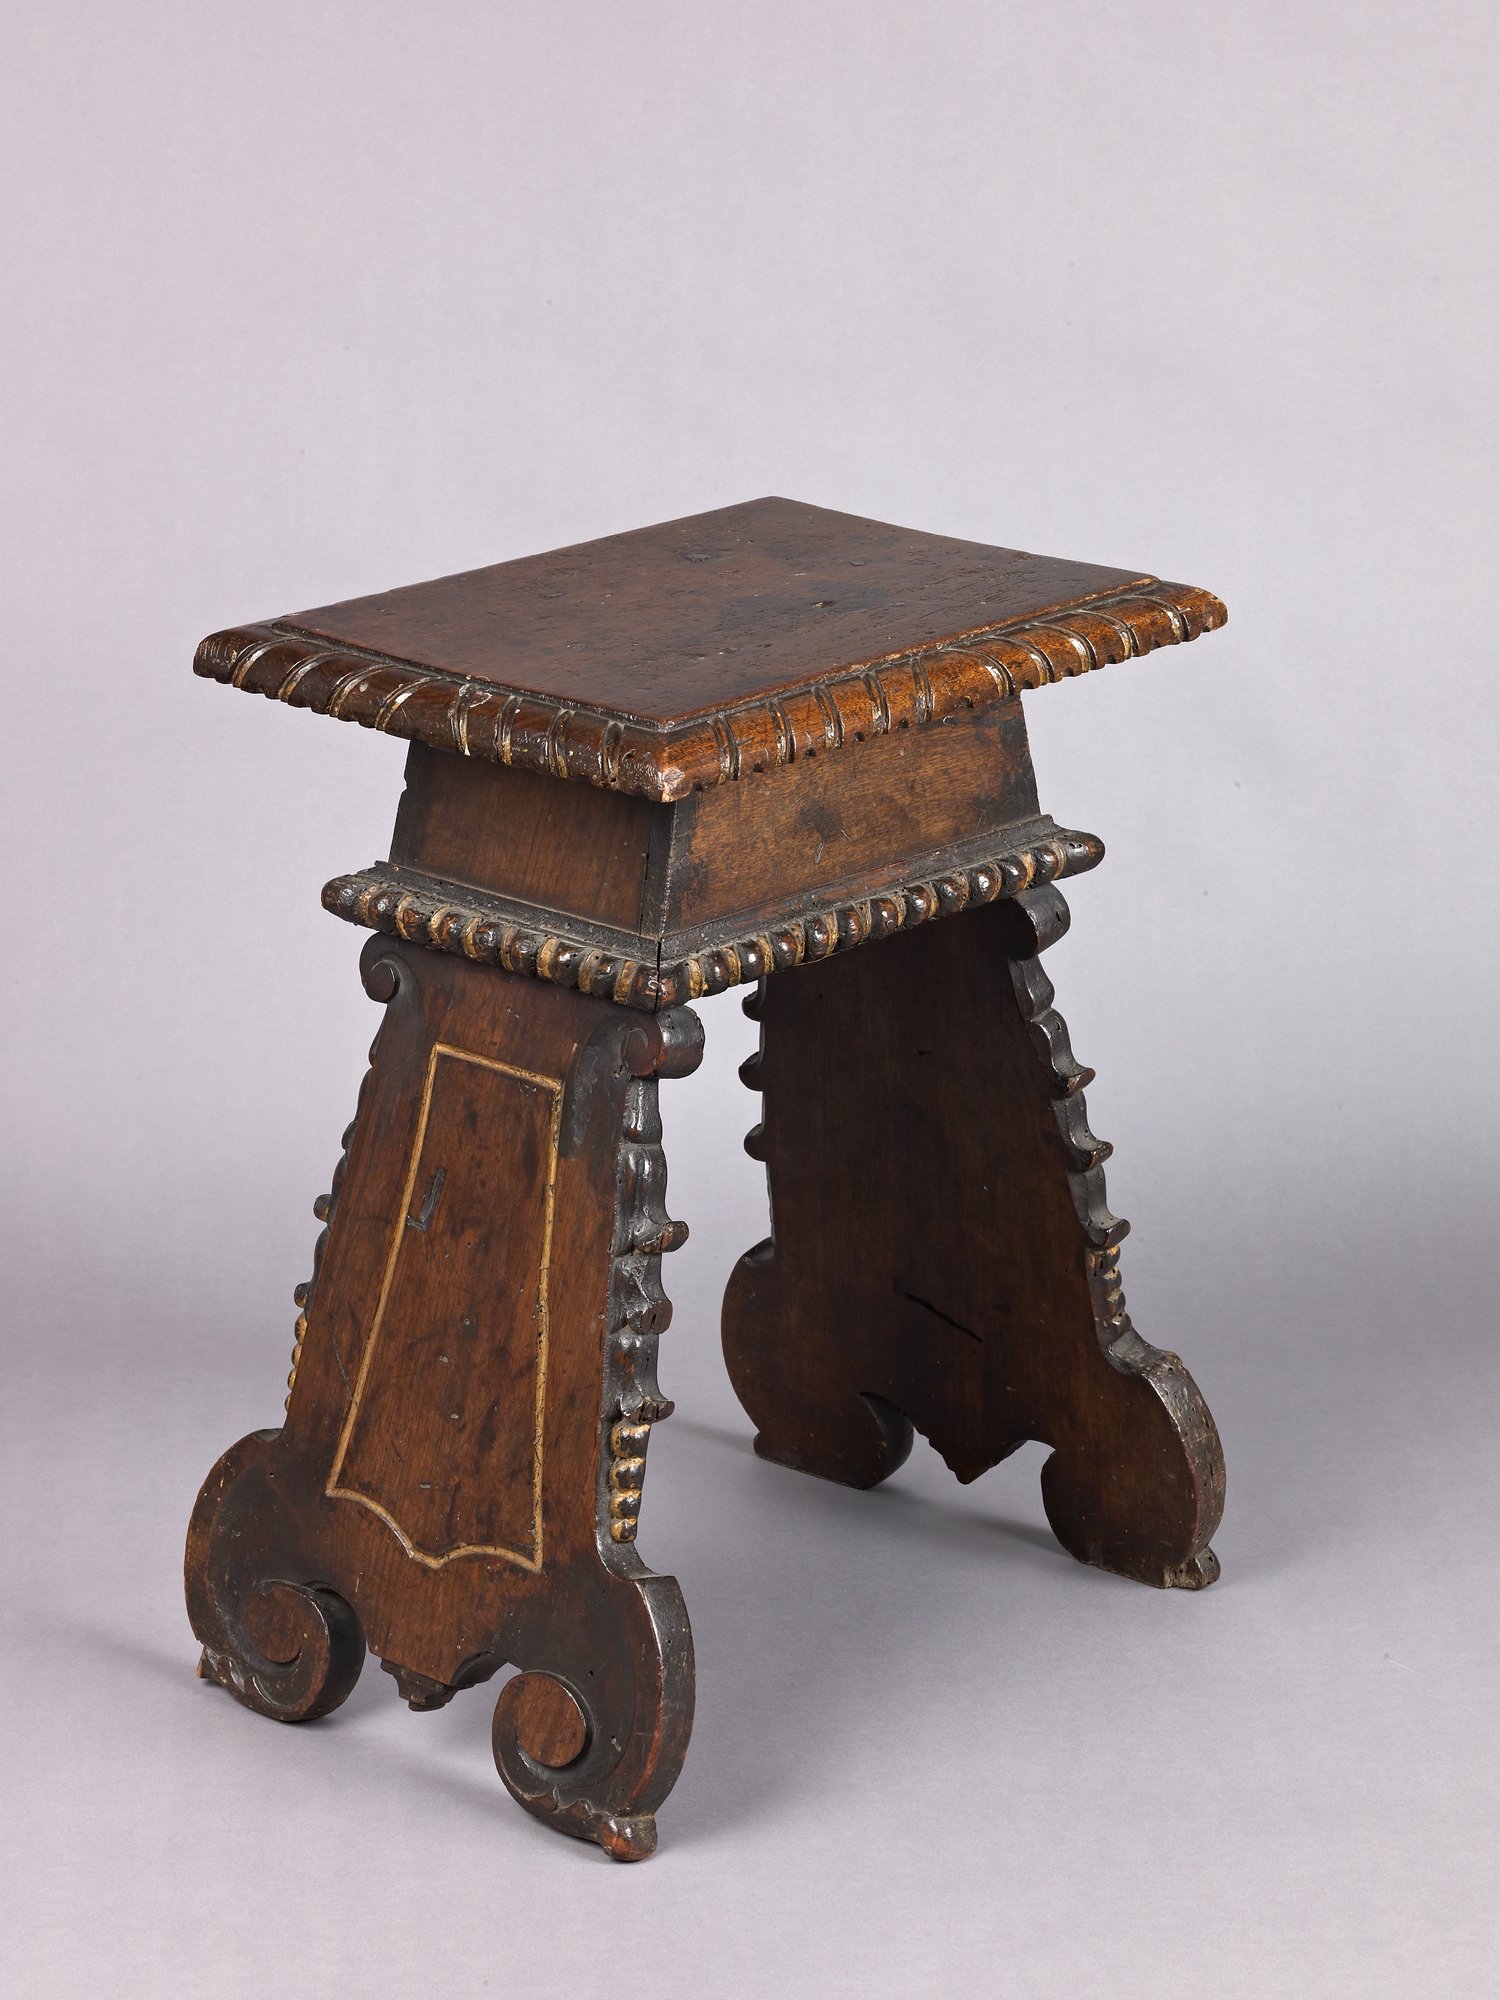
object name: stool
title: Stool (pair with 1975.1.2002)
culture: italian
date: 1501-1600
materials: wood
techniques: carving, gilding